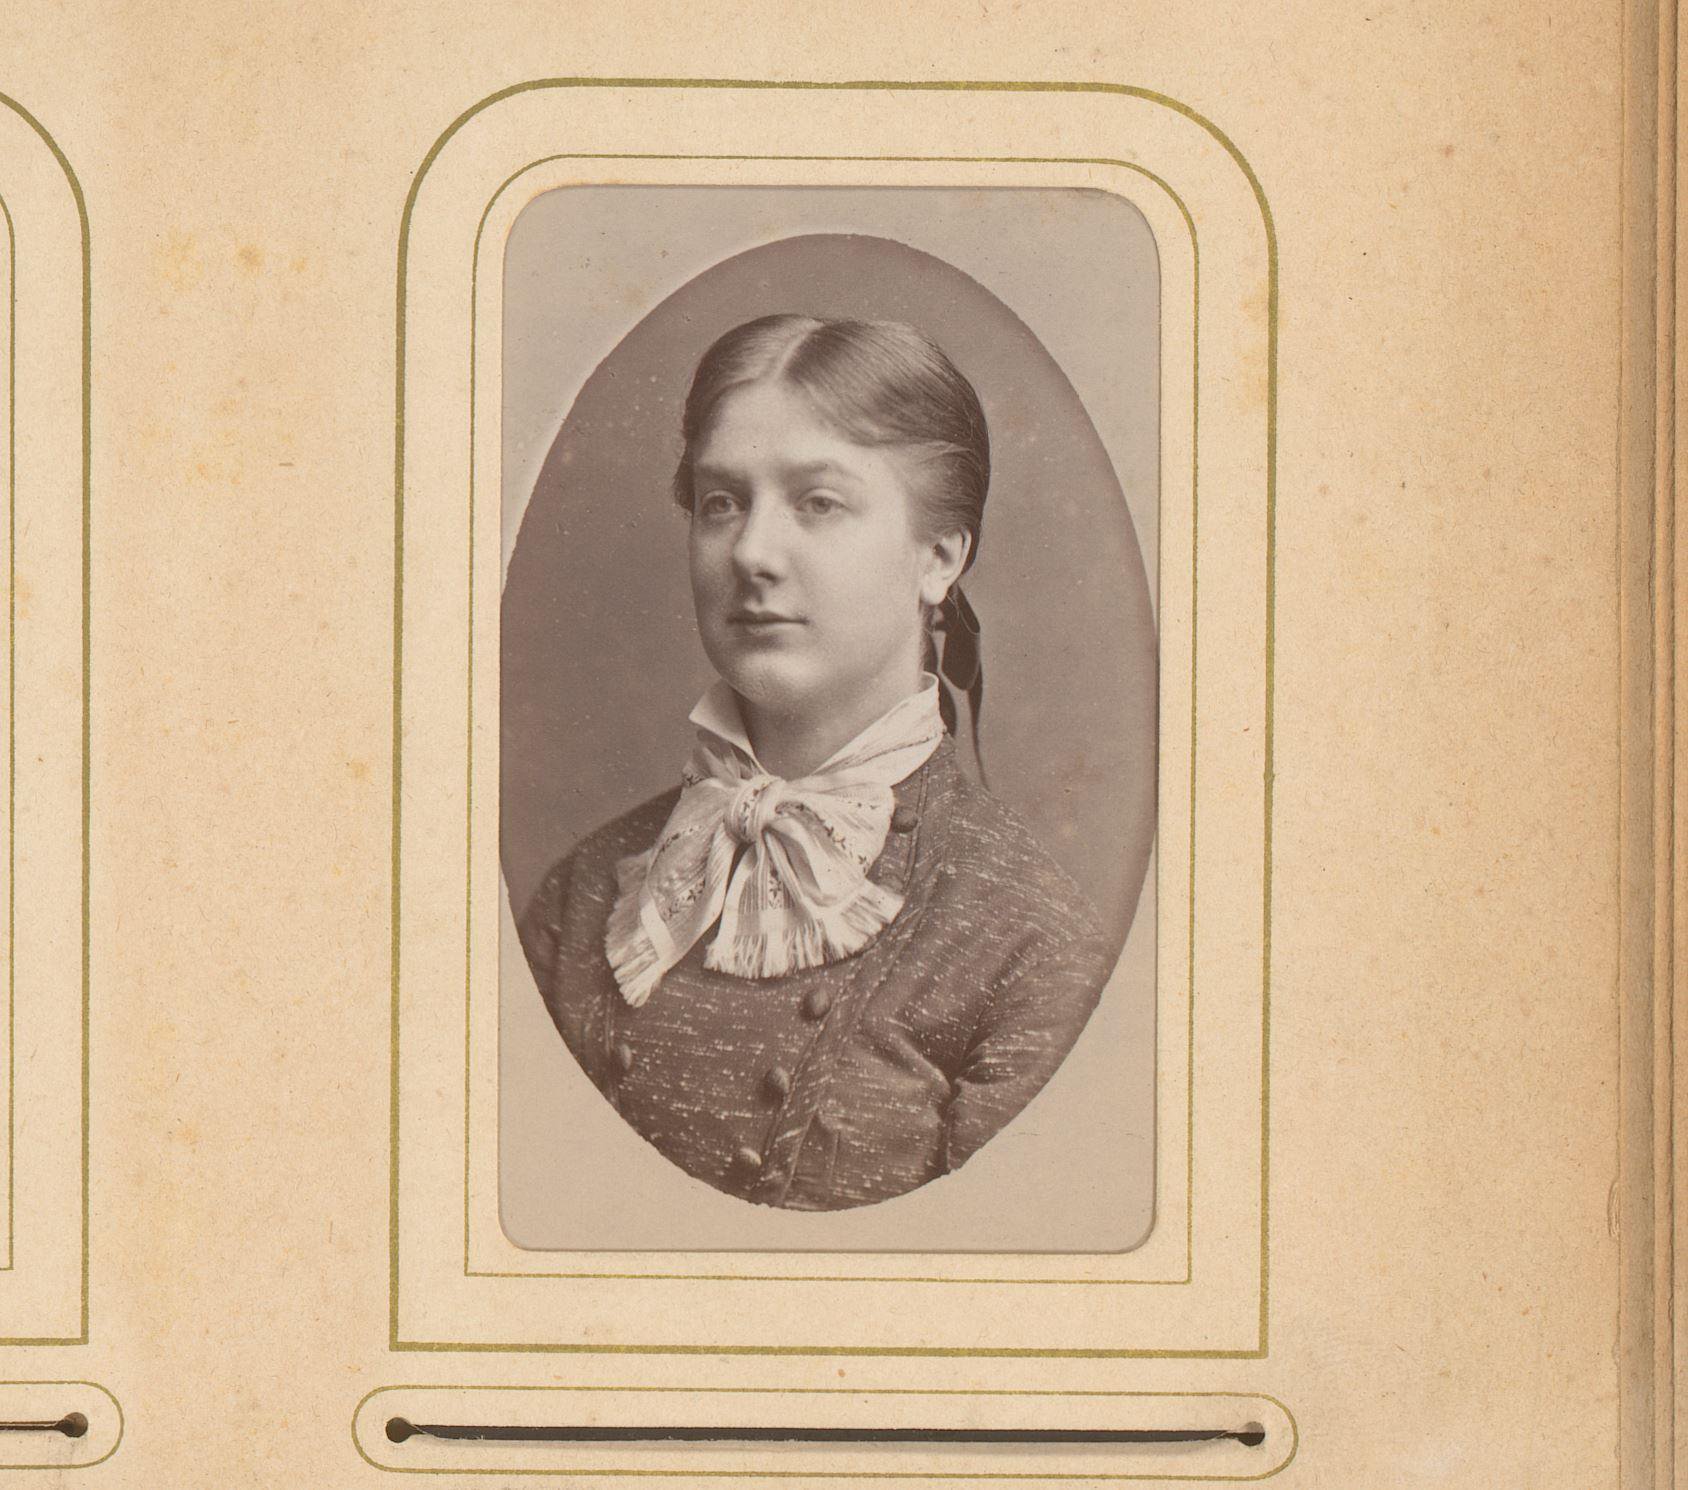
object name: photograph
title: Portret van een jonge vrouw met lint in haar haren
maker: franz wilhelm heinrich deutmann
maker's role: fotograaf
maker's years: 1840-1906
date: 1865-1905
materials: cardboard, photographic support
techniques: albumen print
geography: zwolle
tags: adolescent, young woman, maiden, historical persons - bb - woman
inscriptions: inscription: ‘Photogr. Atelier/ DEUTMANN/ Kamperstraat/ ZWOLLE./ Het cliché wordt voor verdere/ bestellingen bewaard.’